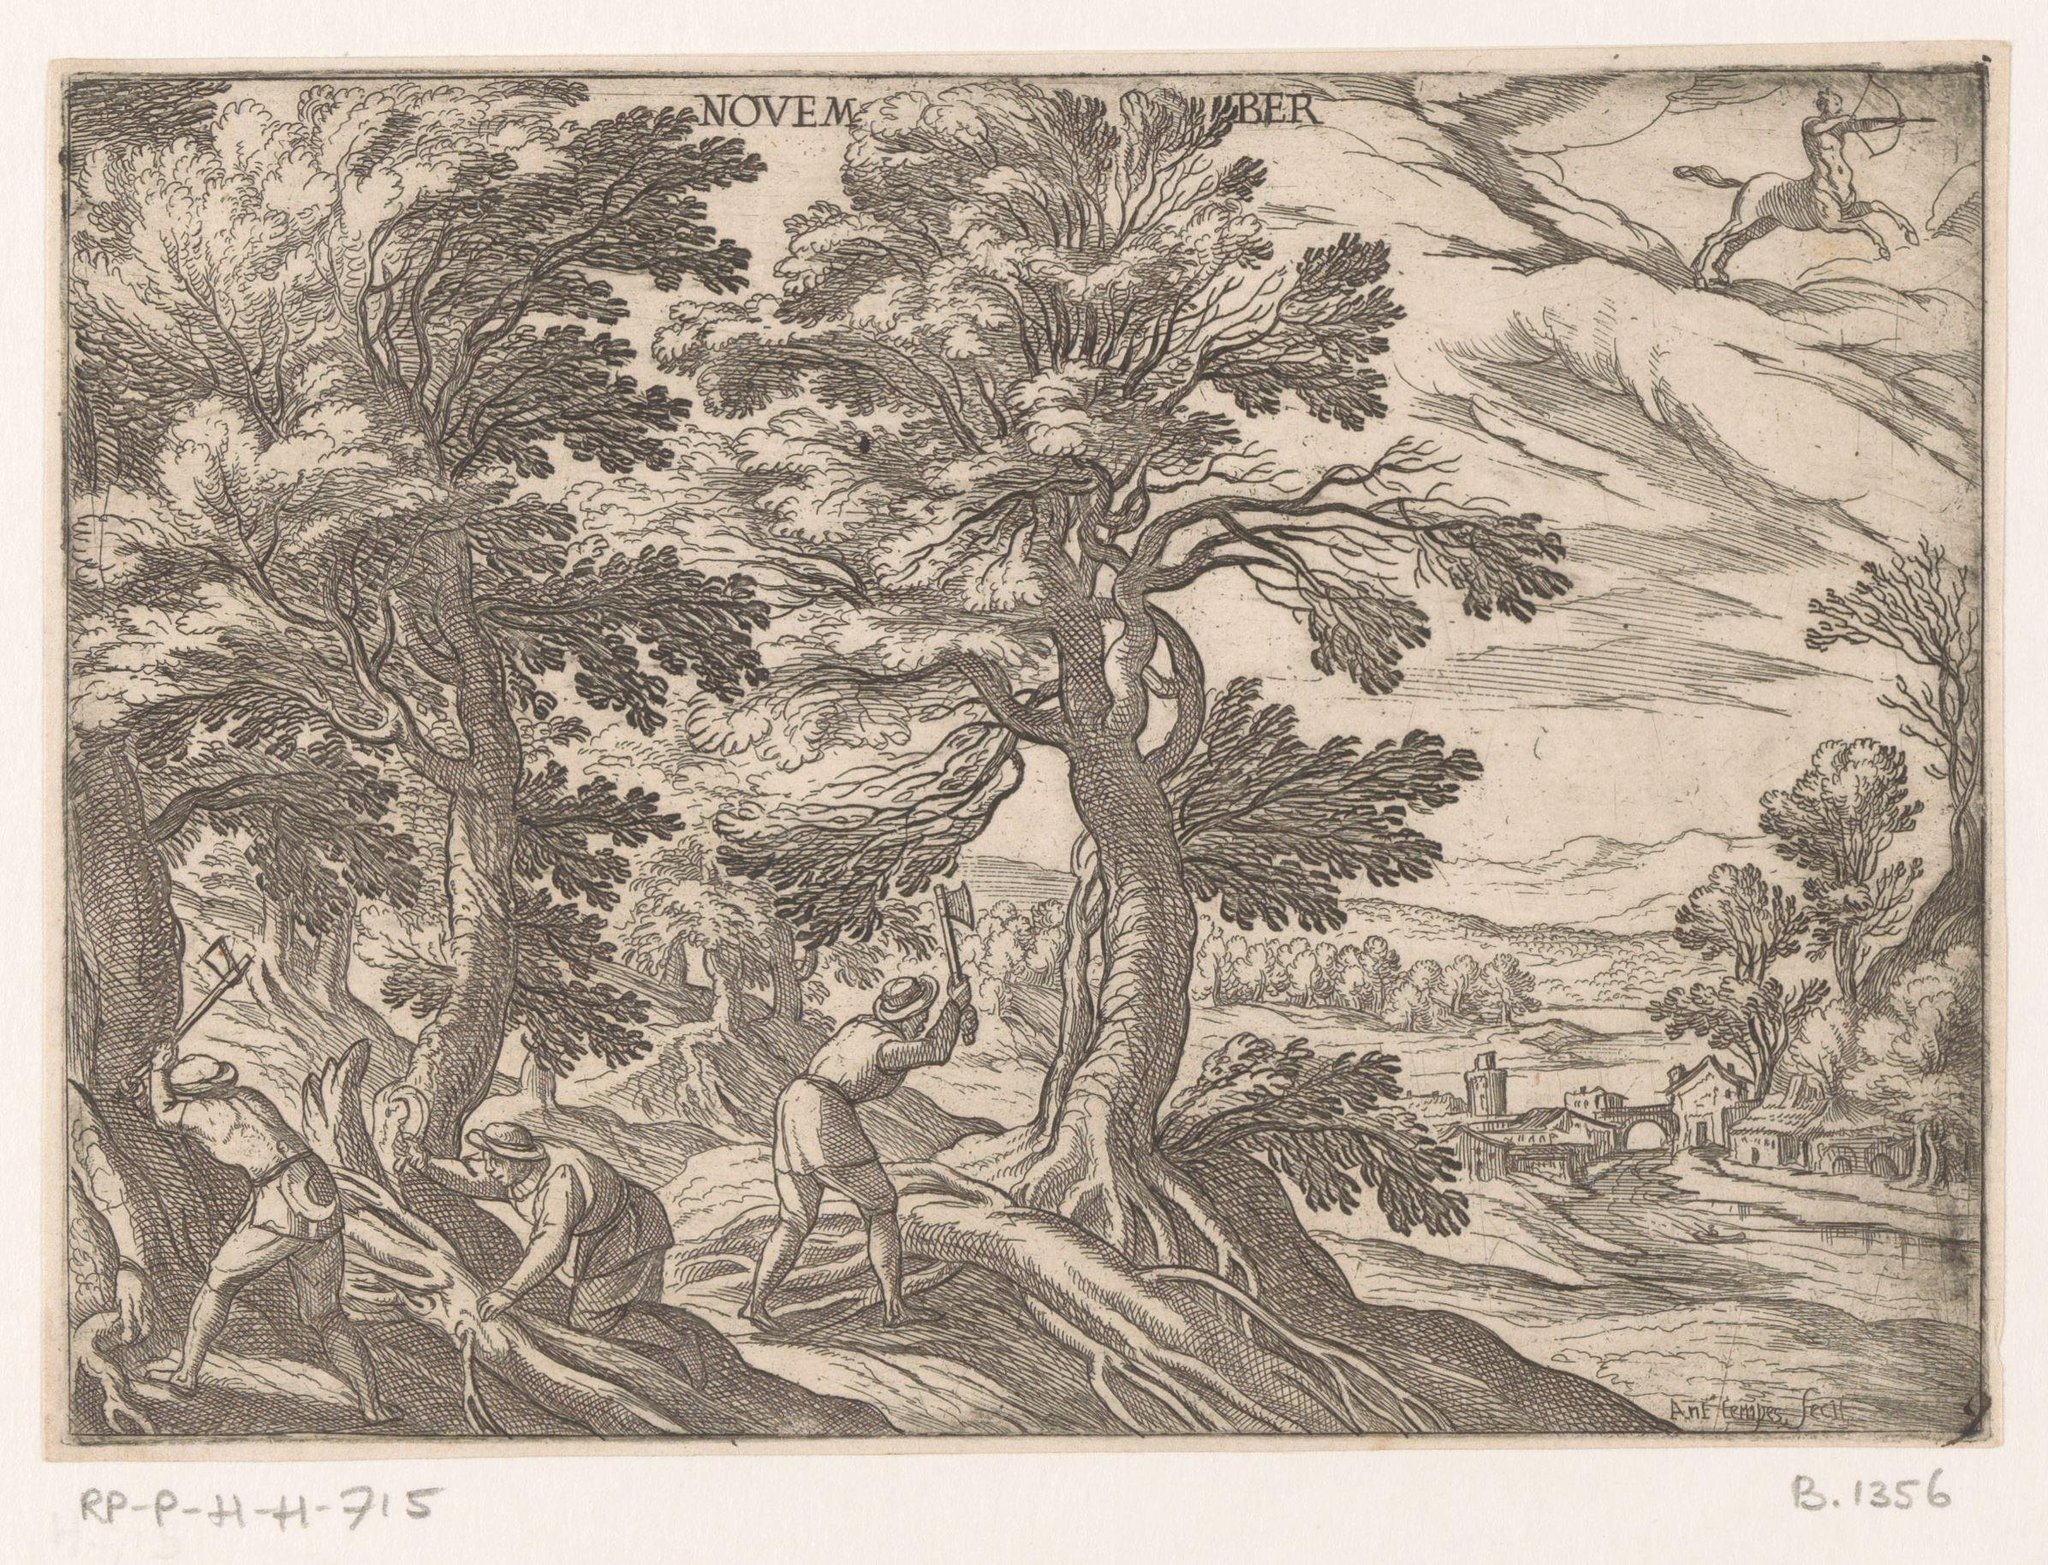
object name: print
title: De twaalf maanden (deel 2)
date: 1575-1613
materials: paper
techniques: etching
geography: italy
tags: landscape symbolizing november, woodcutting, woodcutter ~ forestry, sagittarius (zodiacal sign of november)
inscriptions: collector's mark: Lugt 11, number: ‘9’, collector's mark: ‘Hinloopen’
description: Landschap dat de maand november verbeeldt. Landschap met houthakkers die wortels van bomen kappen. Rechtsboven het symbool voor het sterrenbeeld boogschutter.